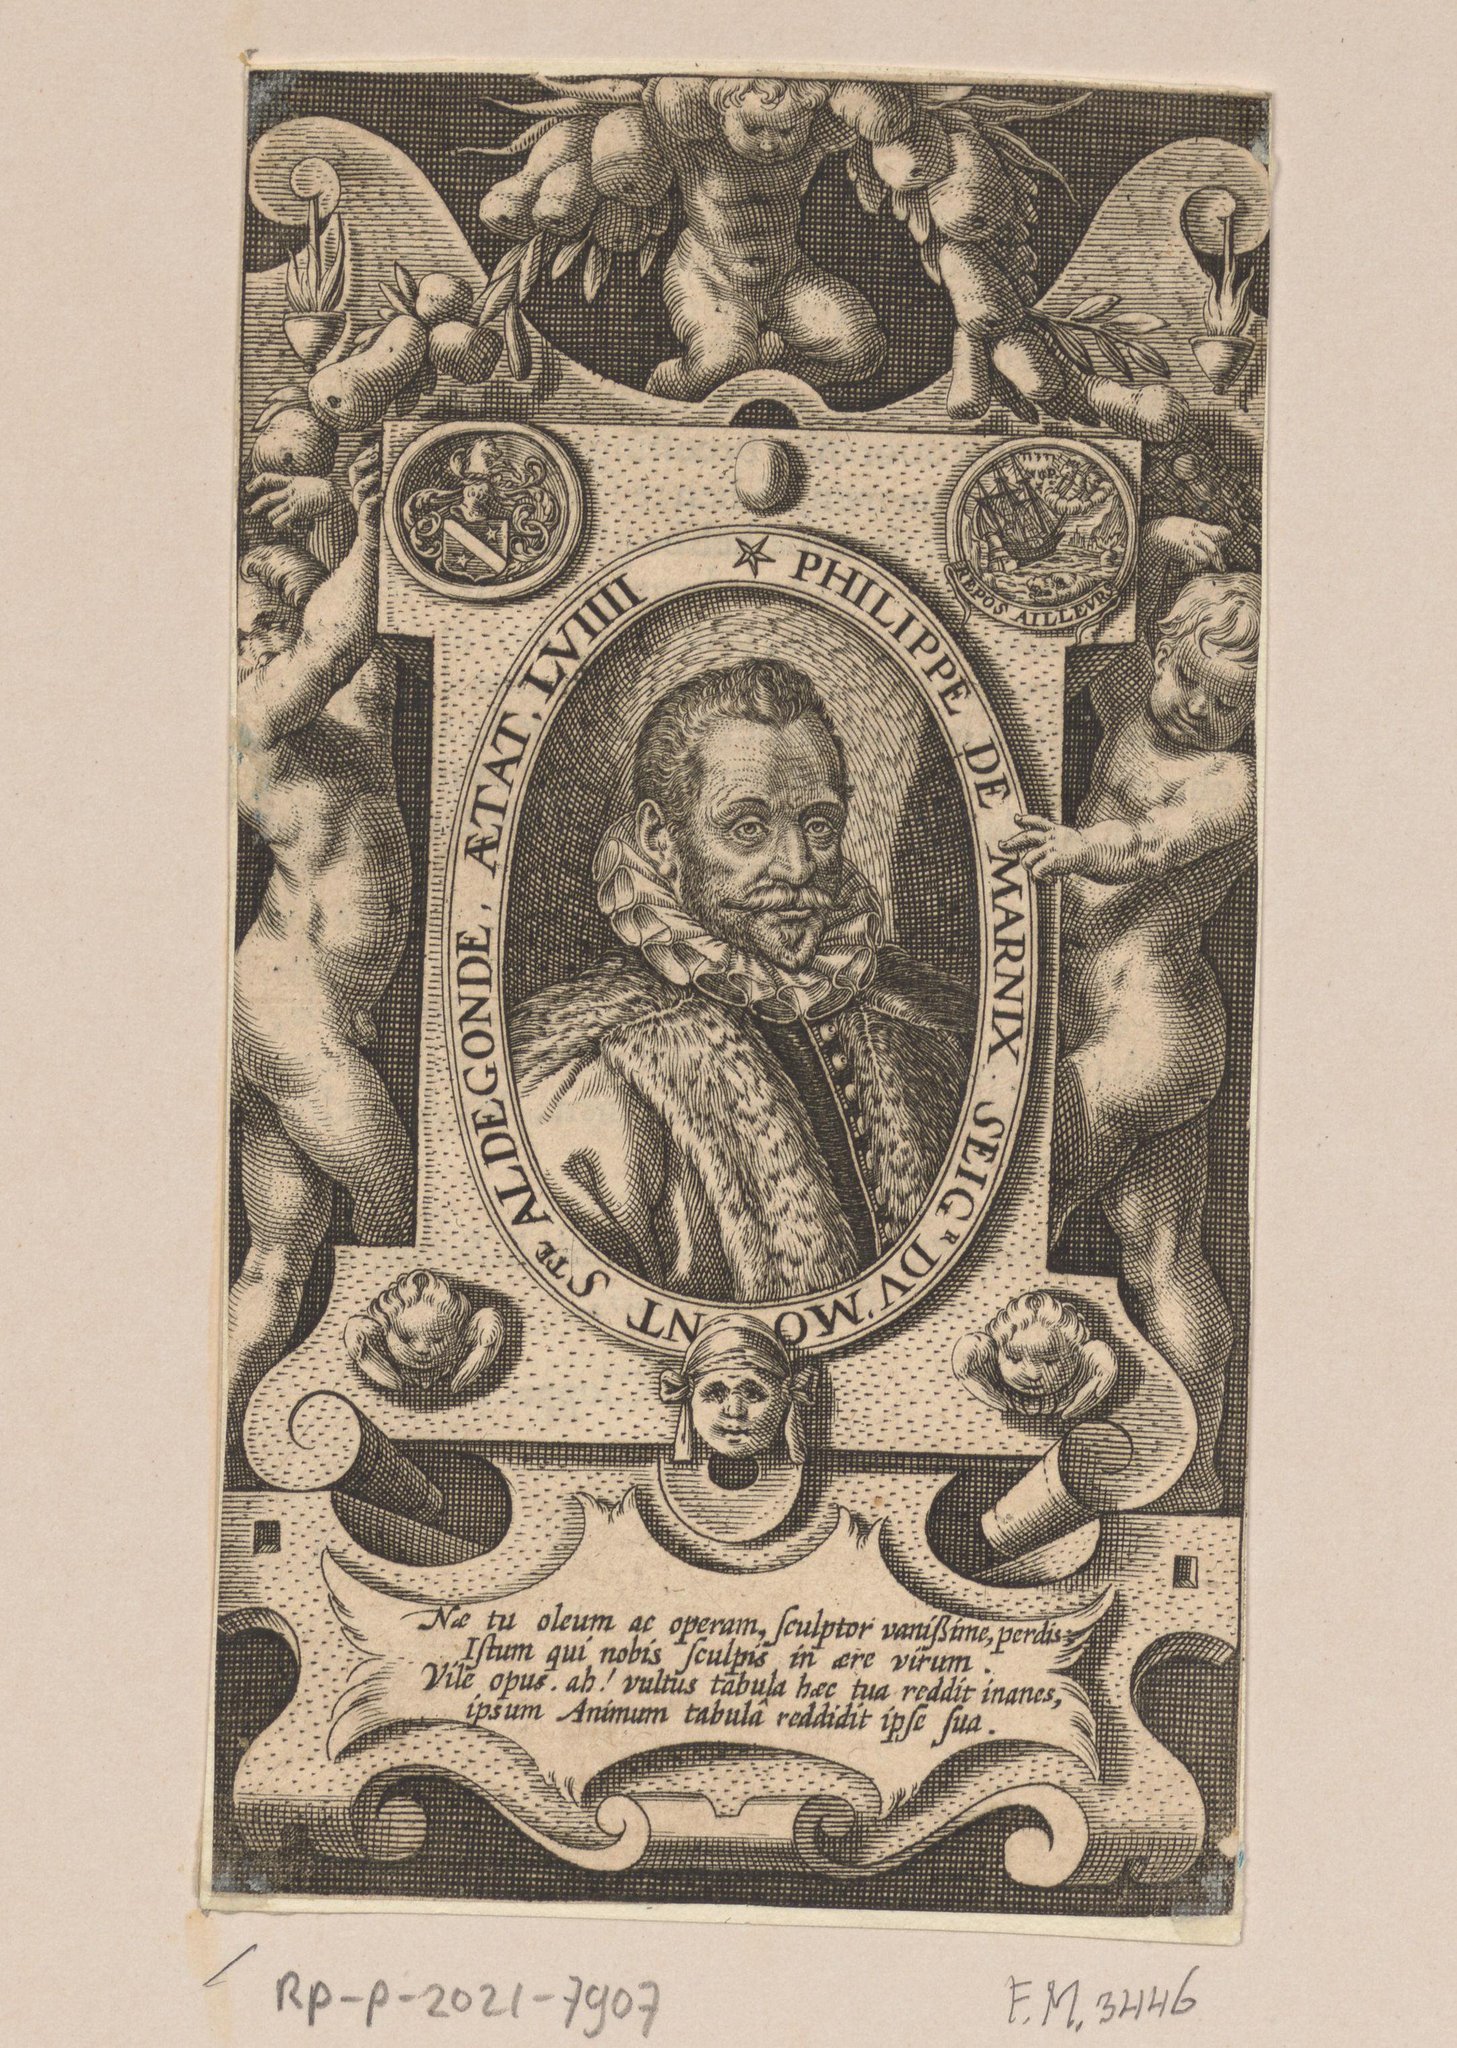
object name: print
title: Portret van Filips van Marnix van Sint-Aldegonde op 59-jarige leeftijd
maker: Anonymous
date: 1601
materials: paper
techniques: engraving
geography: northern netherlands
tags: brussels, leiden, politician, filips van marnix van sint-aldegonde, fruits and vegetables ~ ornament, ornament ~ medallion, historical persons, portrait of a writer, armorial bearing, heraldry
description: Filips van Marnix van Sint-Aldegonde overleed in 1598 en was toen waarschijnlijk 58 jaar oud, en niet 59 zoals op de prent vermeld. Prent waarschijnlijk uit: Marnix van Sint-Aldegonde, Filips van. Tafereel der religions verschillen (...). Amsterdam: Jan Evertsz. Cloppenburgh, 1601.